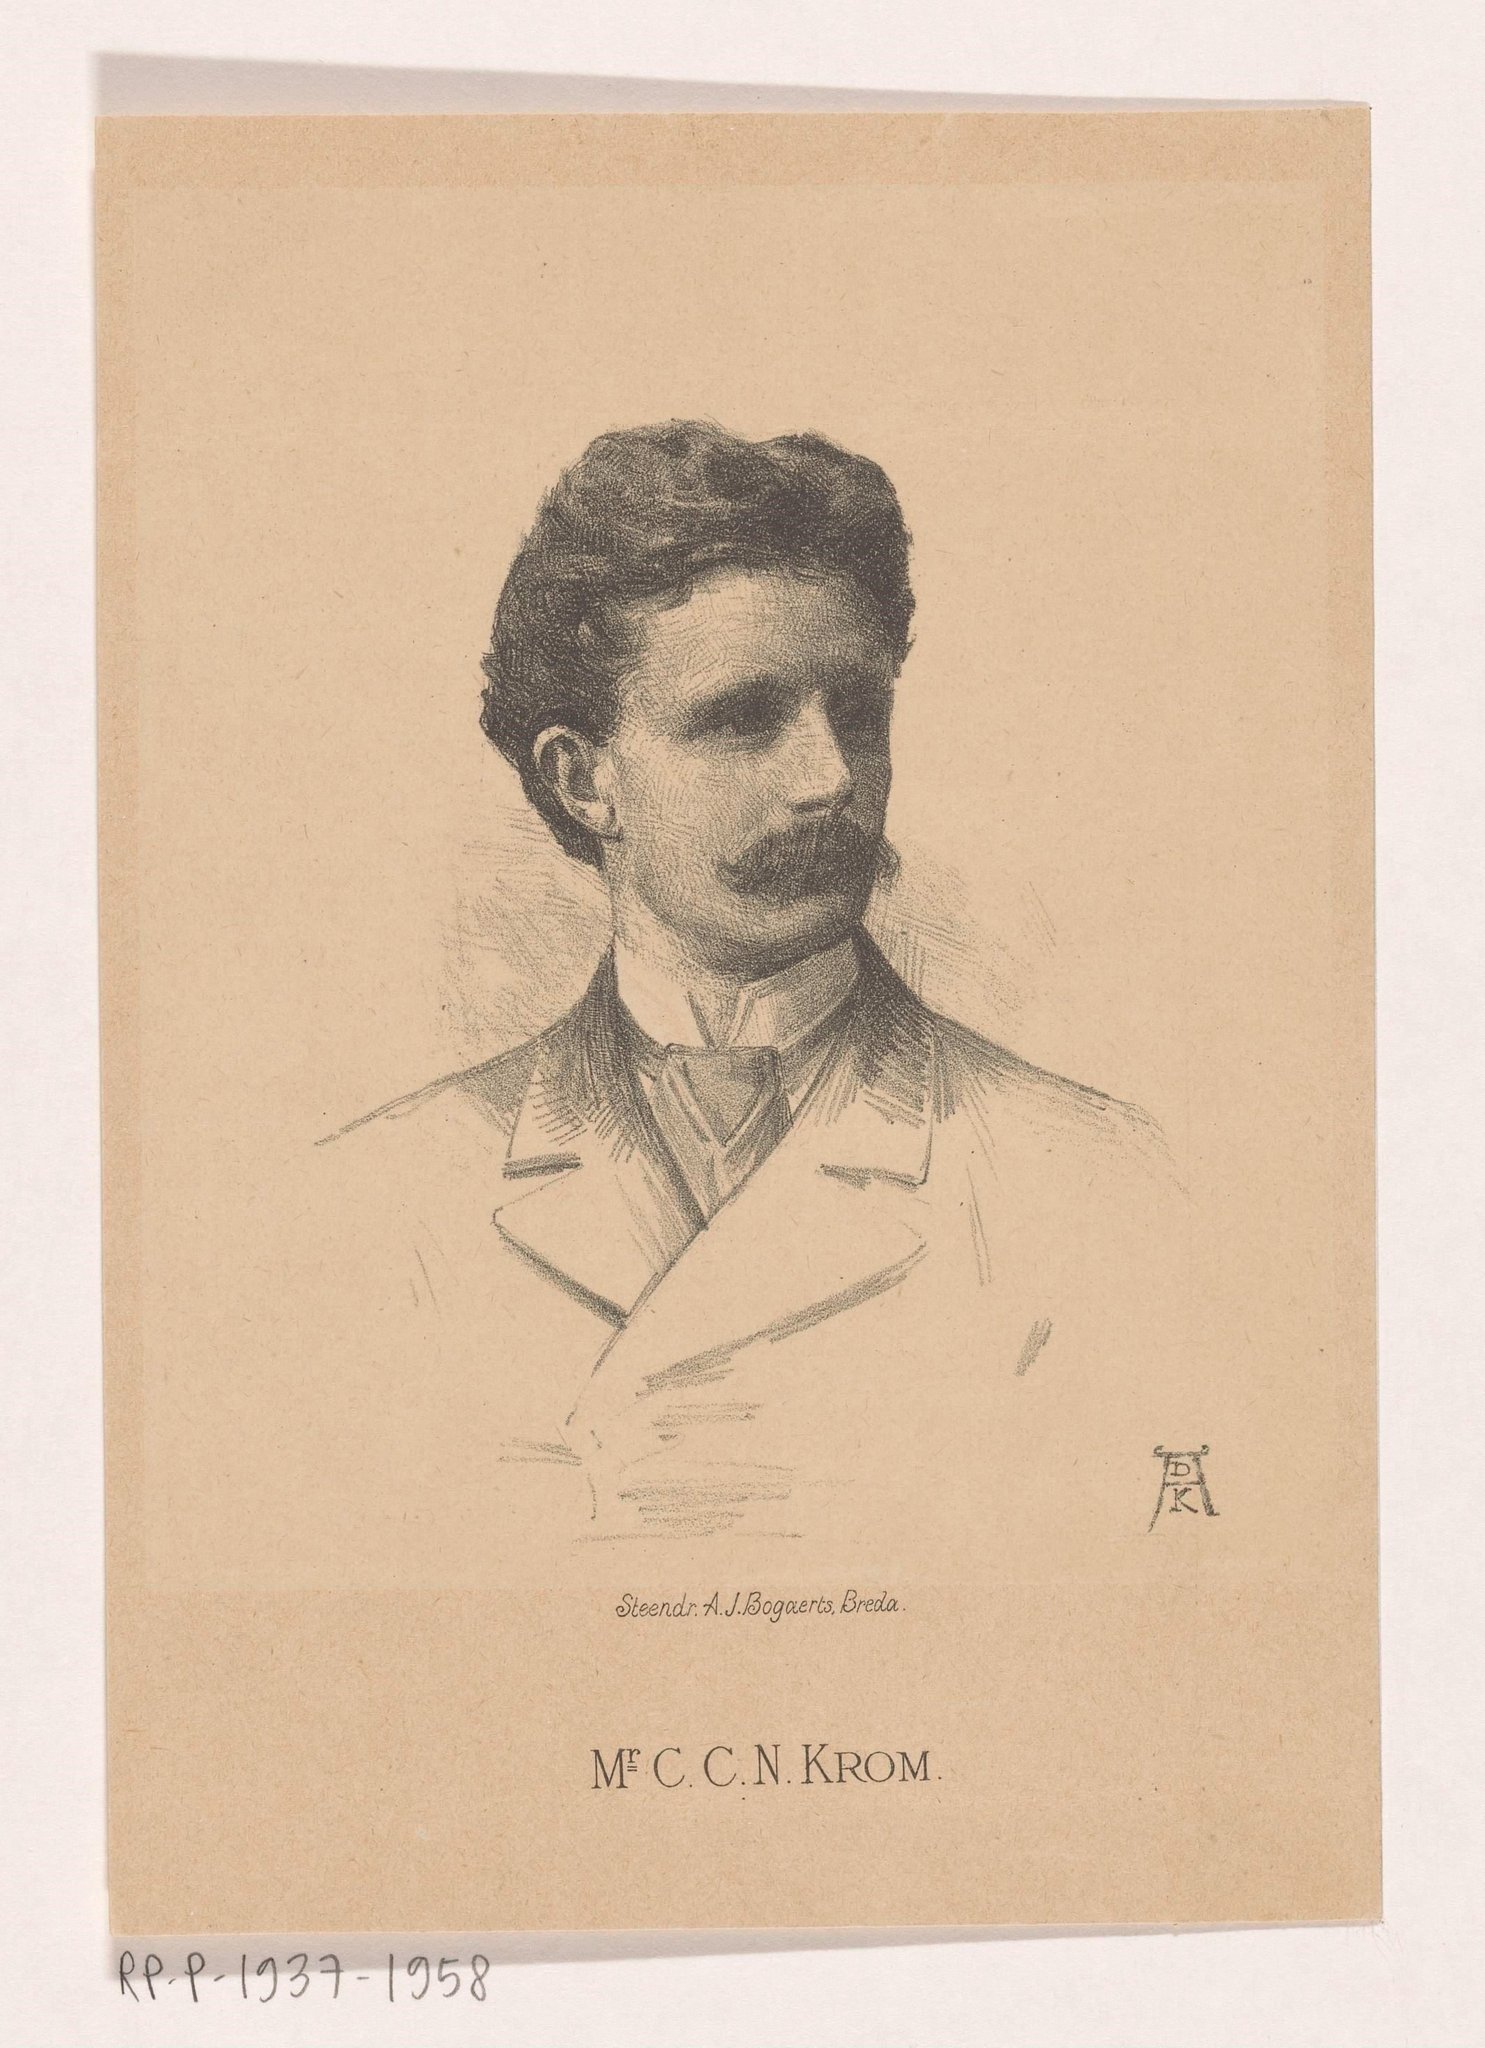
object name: print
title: Portret van Cornelius Catharinus Nicolaas Krom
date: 1869-1882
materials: paper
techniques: lithograph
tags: historical persons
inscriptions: collector's mark: Lugt 2760, collector's mark: Lugt 2228